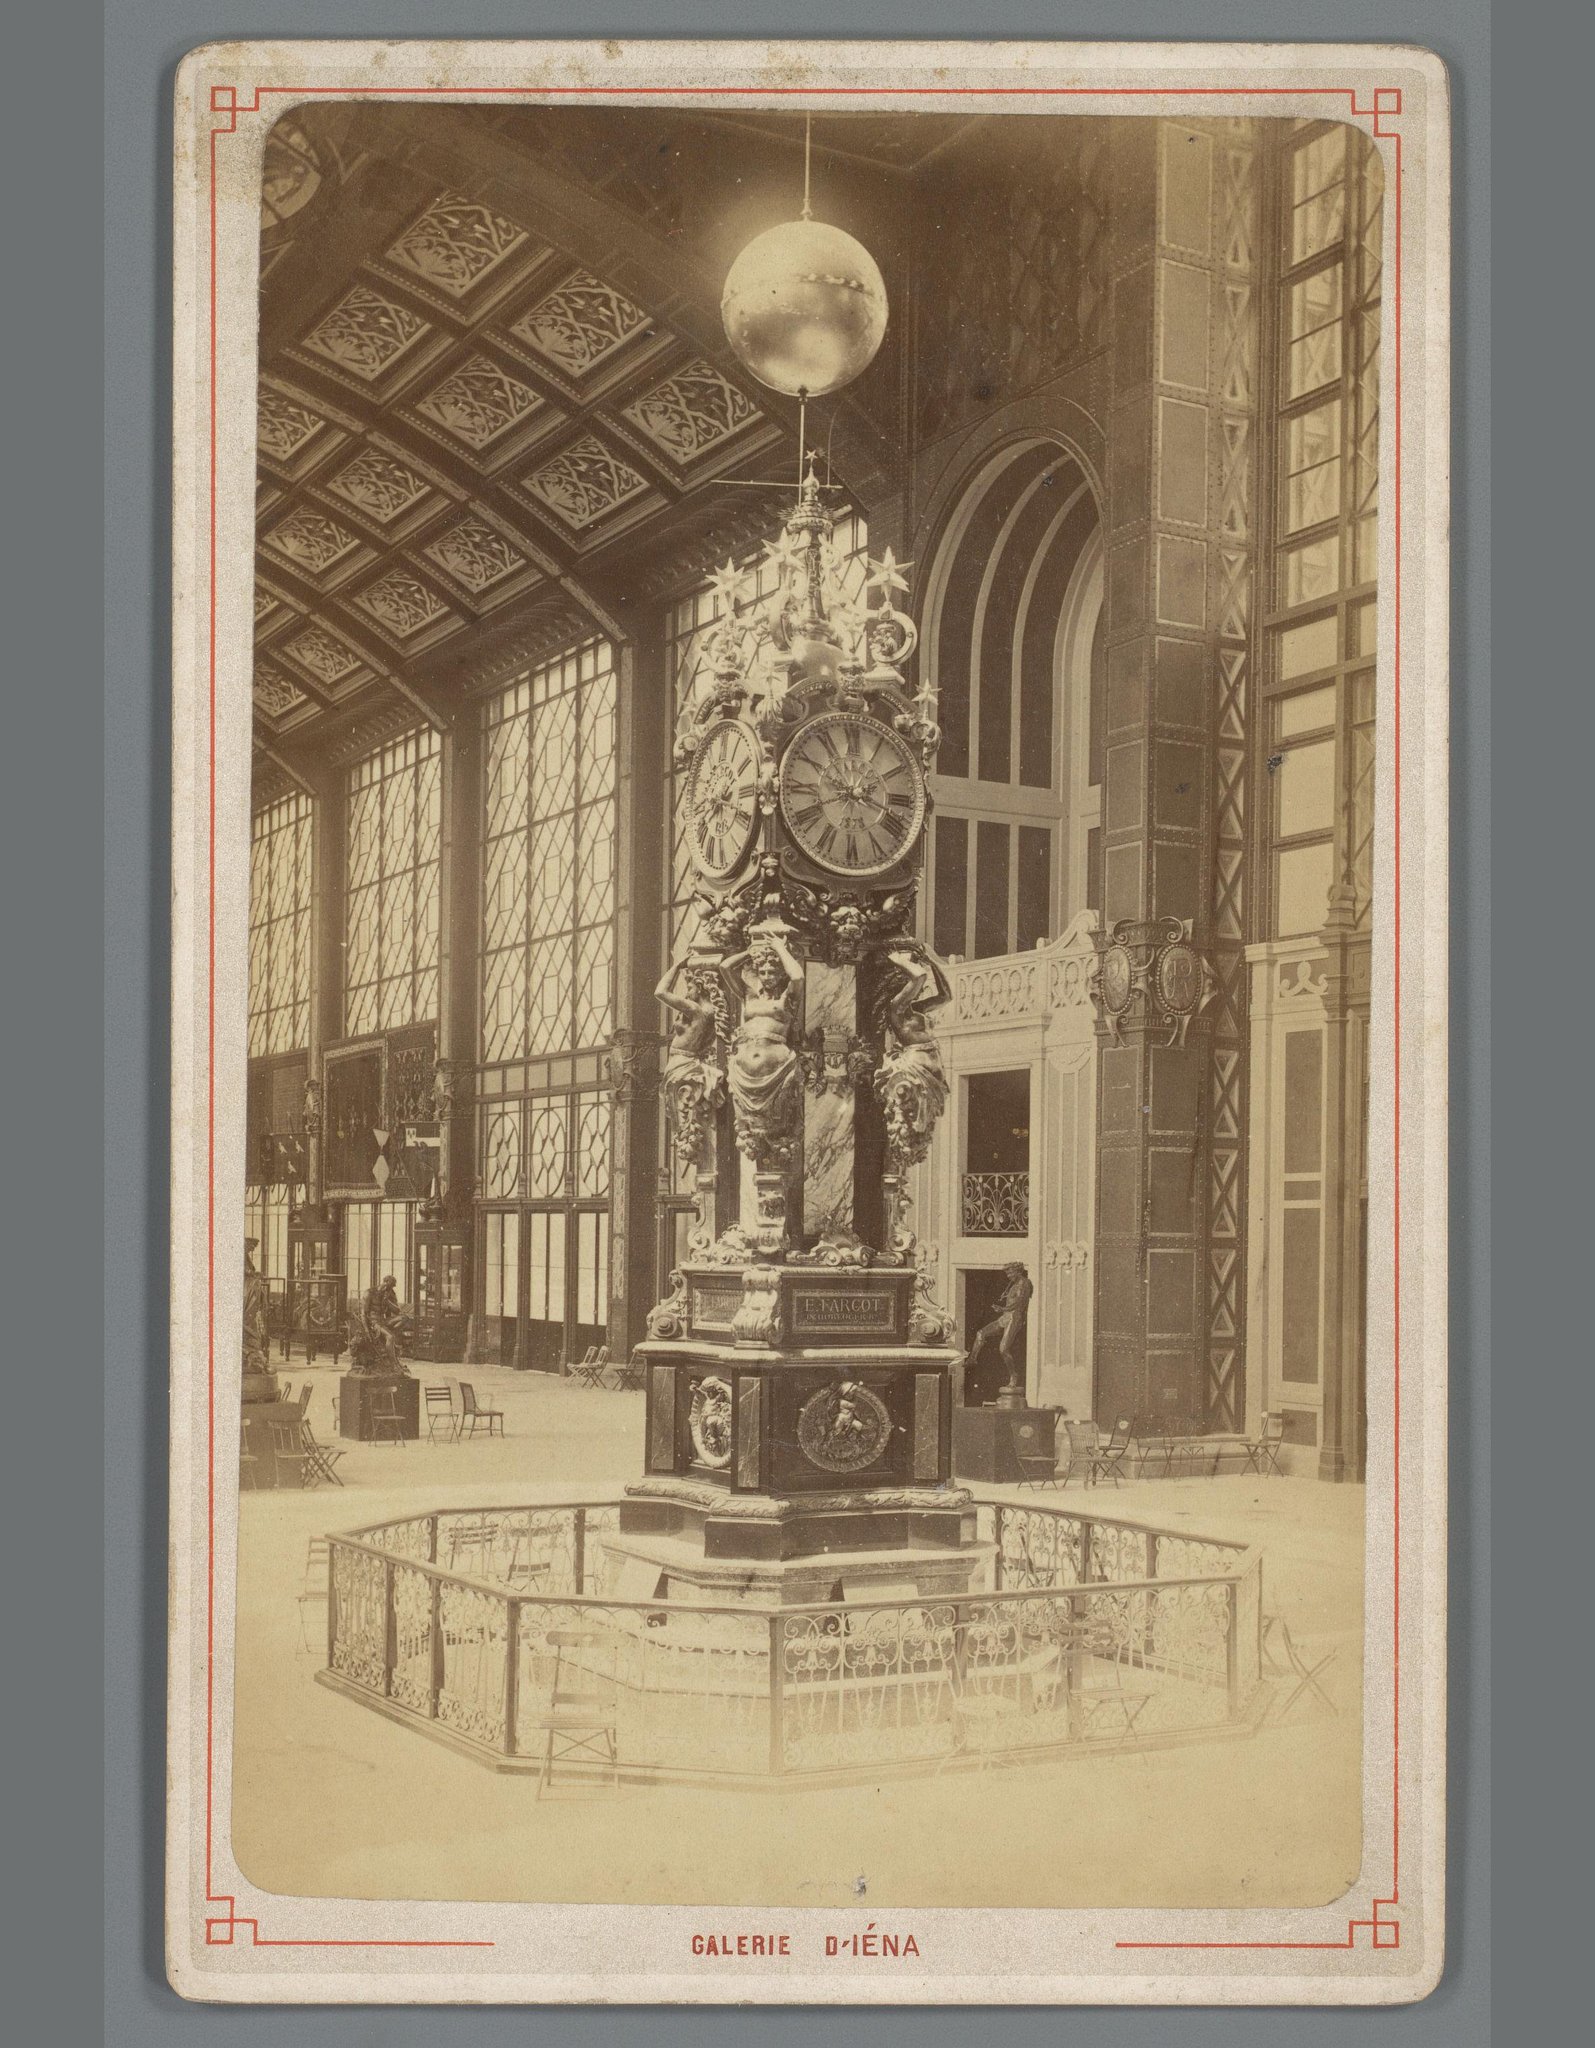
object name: cabinet photograph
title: Galerie d'Iéna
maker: Anonymous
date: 1878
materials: cardboard, paper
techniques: albumen print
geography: paris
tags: world fair, world exhibition, clock, paris